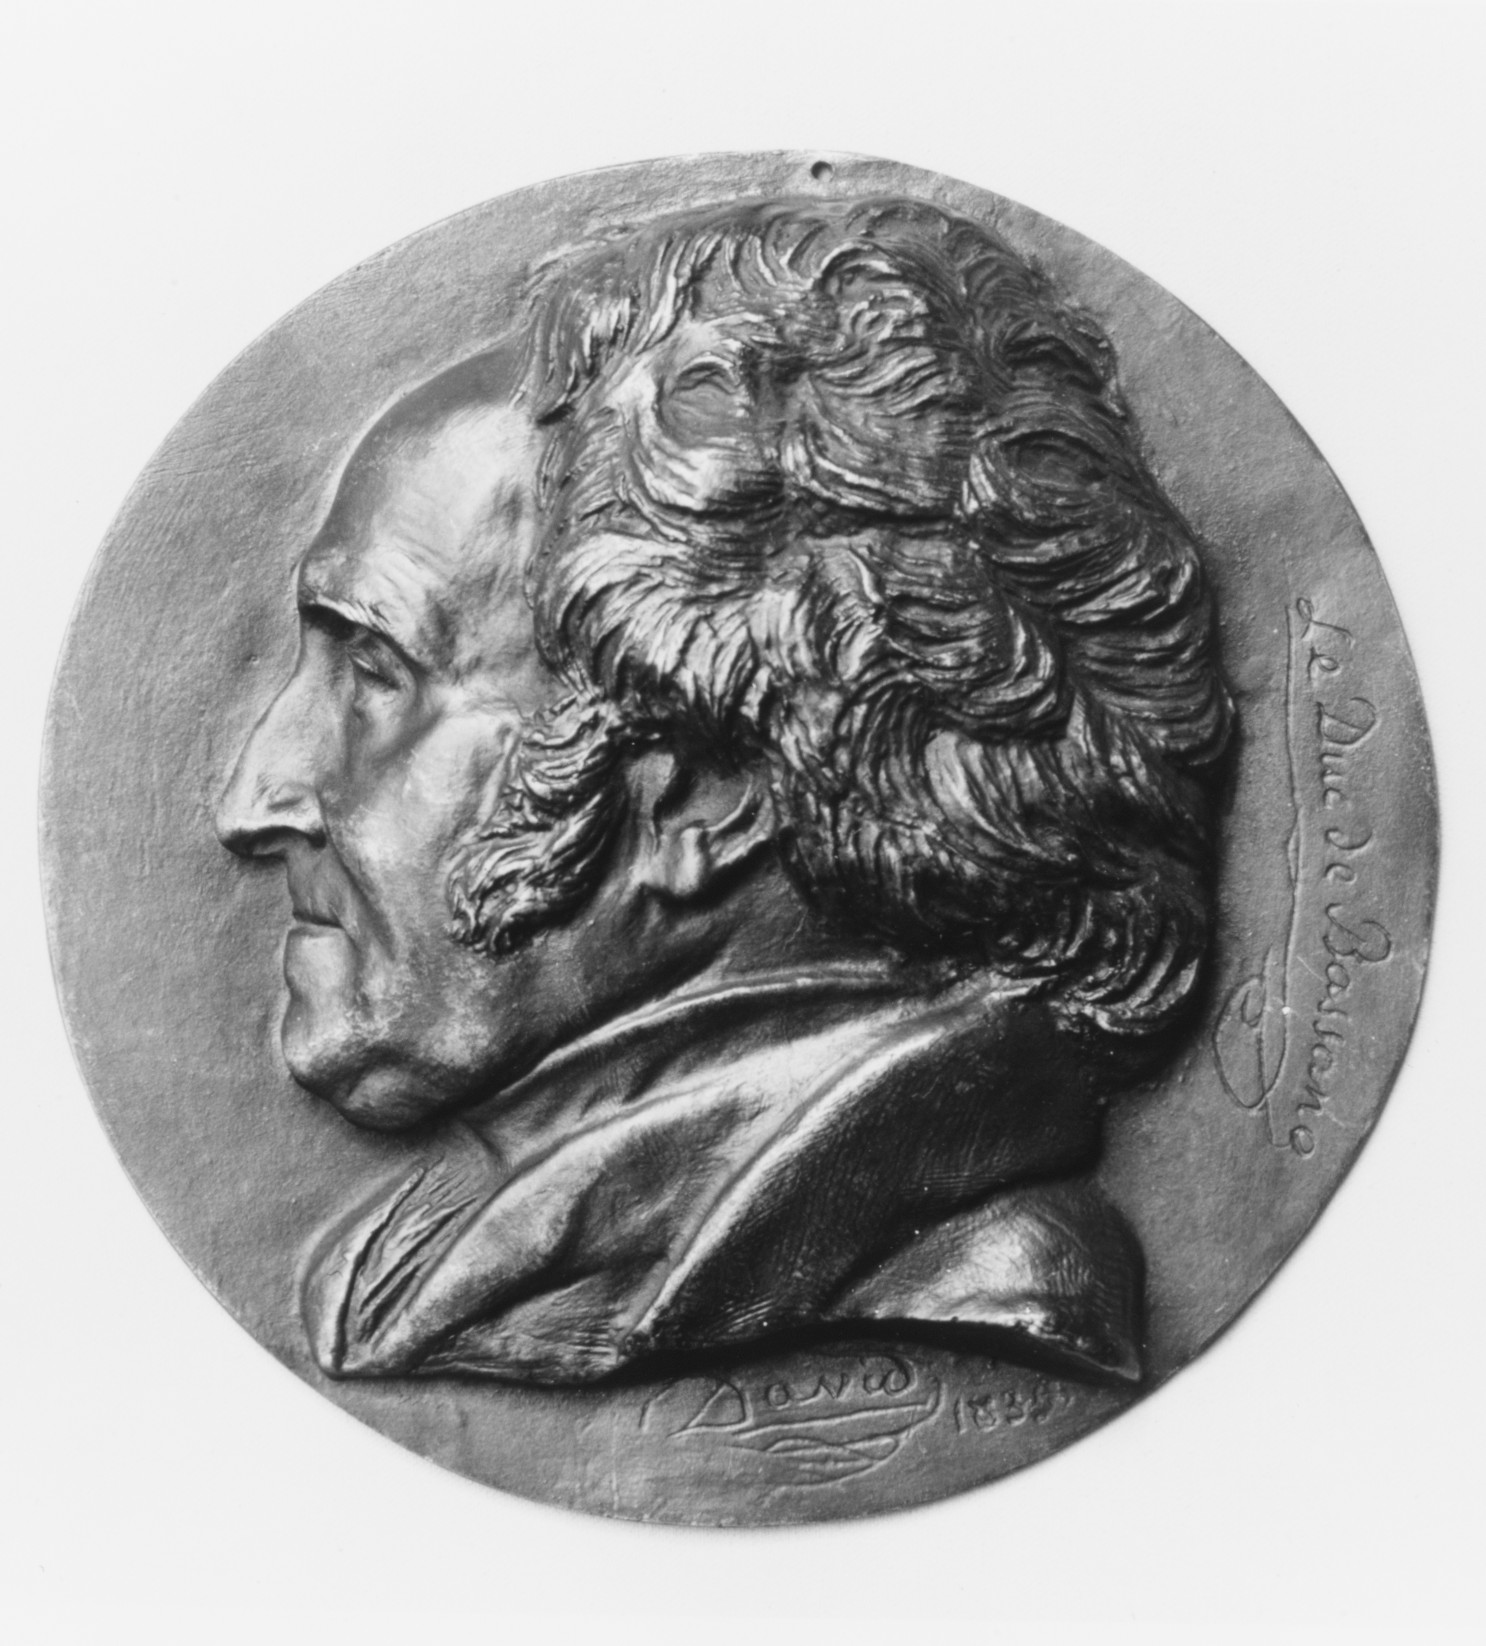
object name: medallion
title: Hughes Bernard Maret, Duc de Bassano (1763–1839)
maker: pierre jean david d'angers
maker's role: artist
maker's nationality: french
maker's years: 1788-1856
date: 1835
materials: bronze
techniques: casting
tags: men,profiles